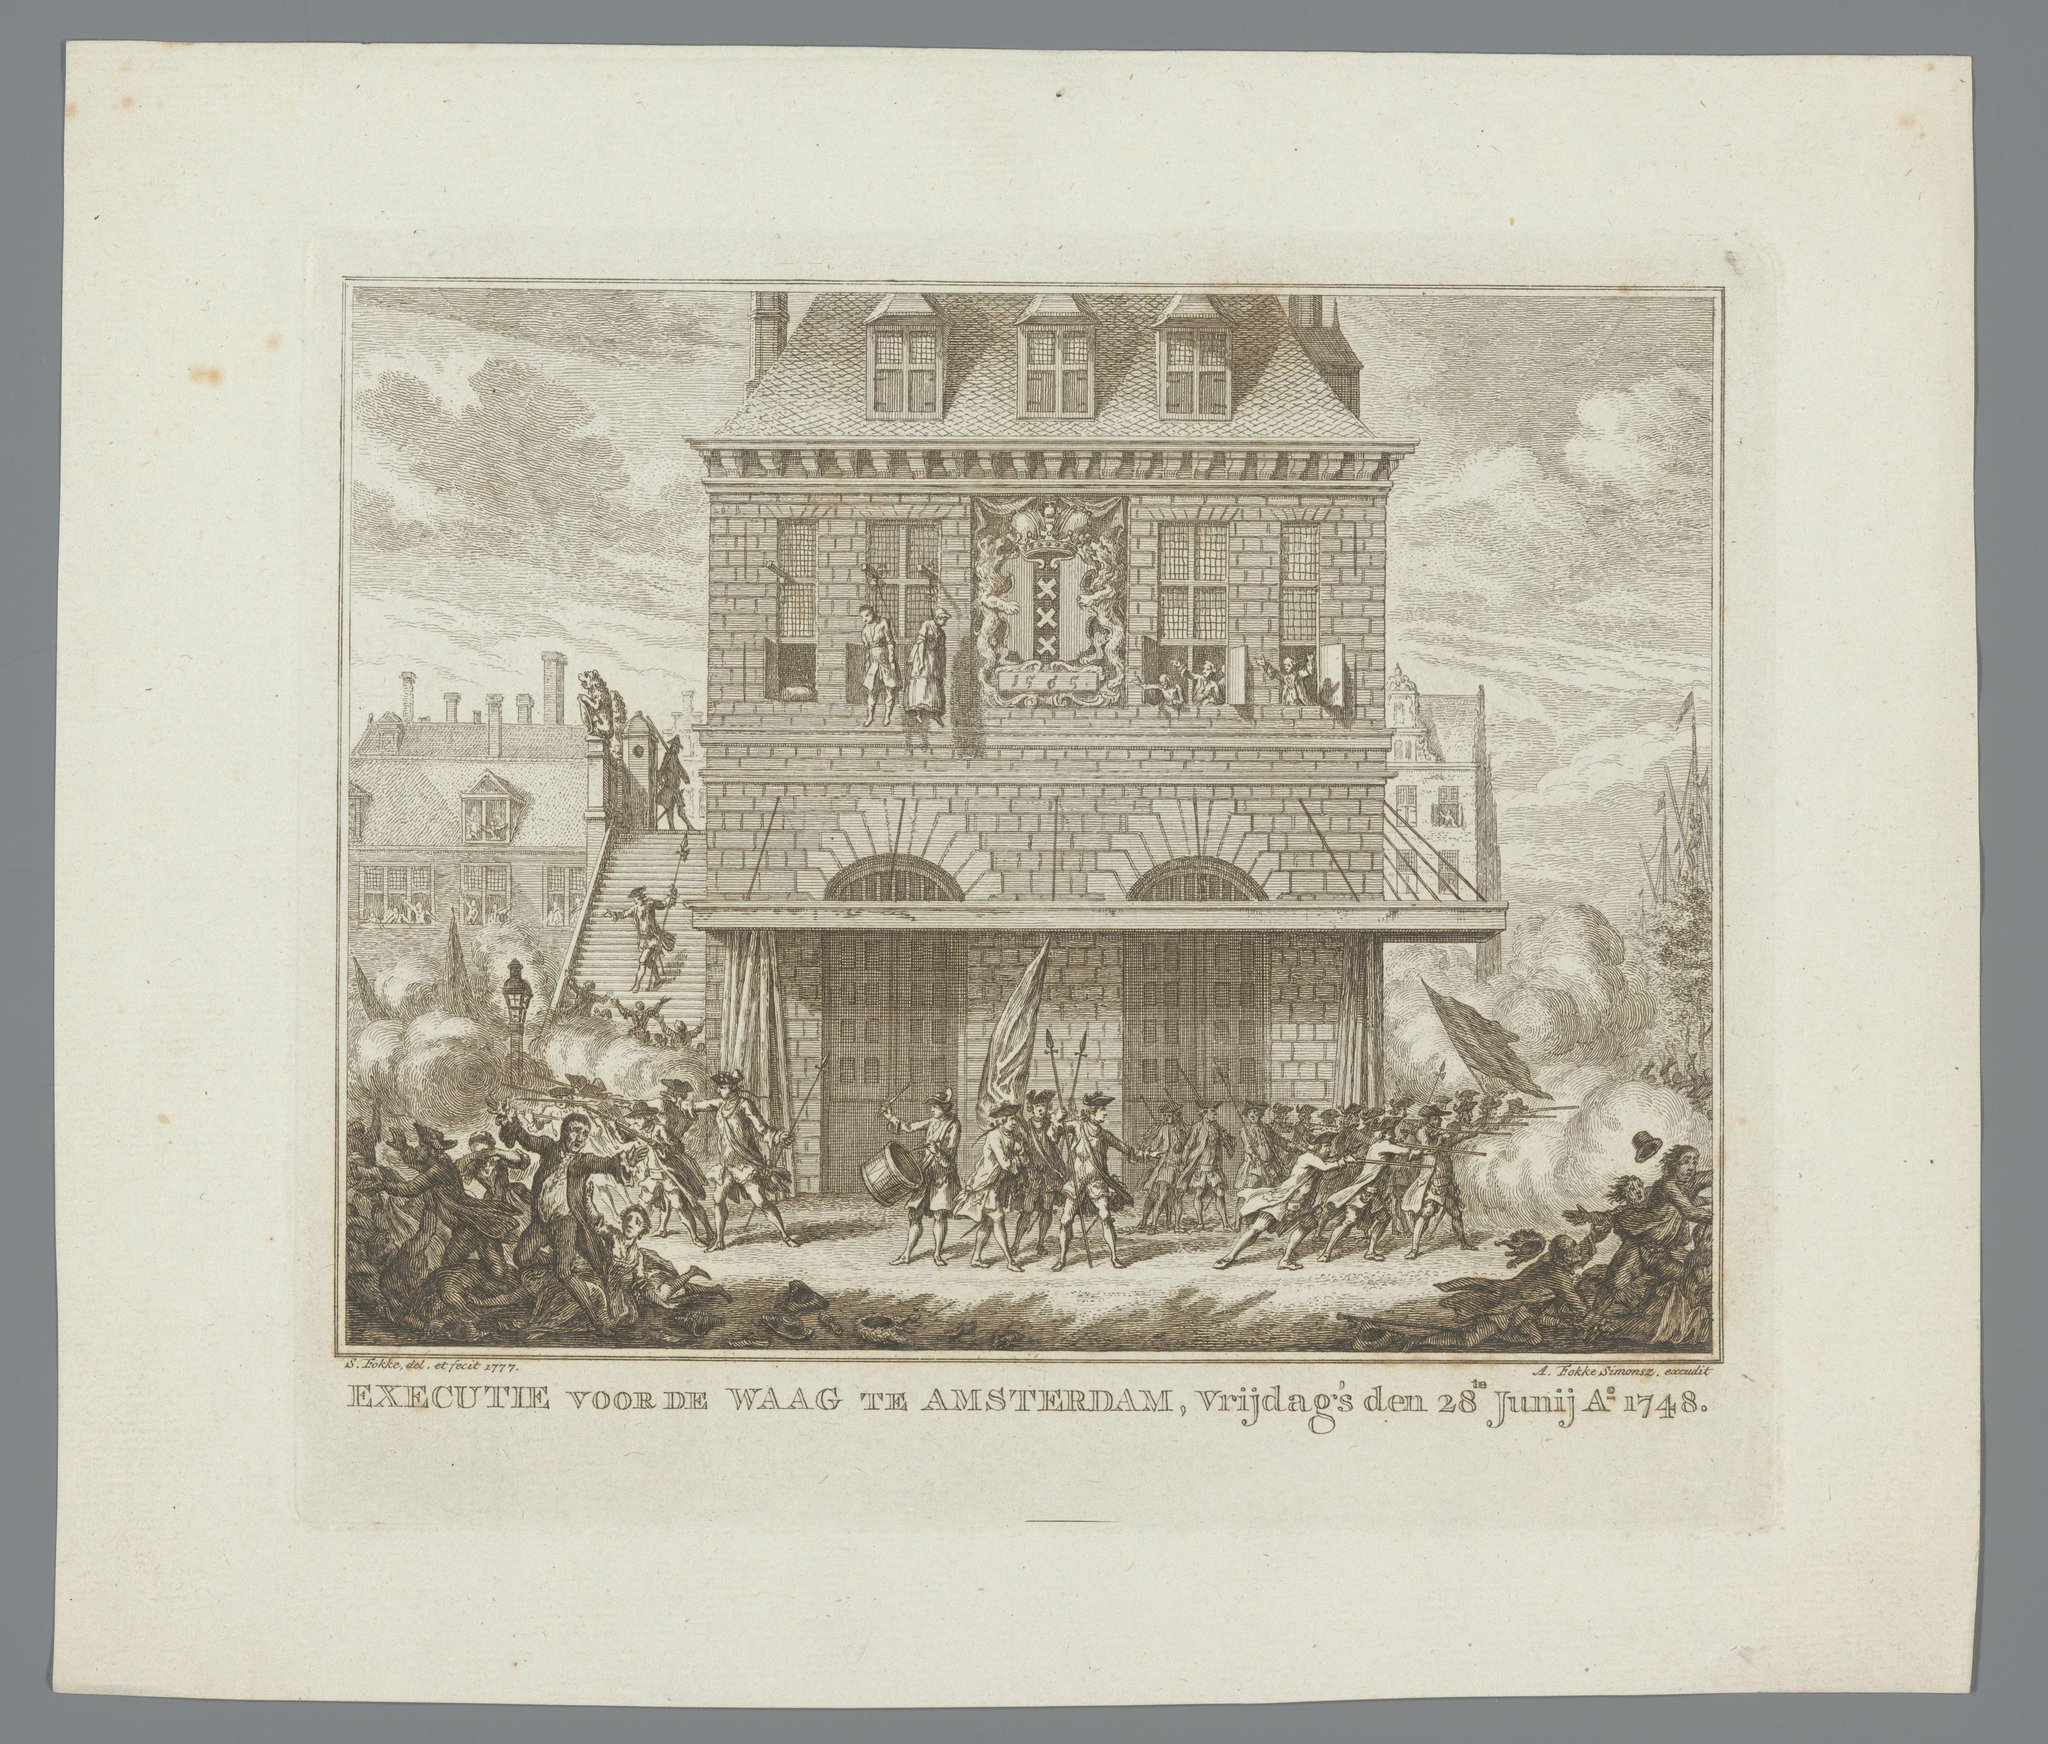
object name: book illustration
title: Executie voor de Waag te Amsterdam, Vrijdag's den 28te Junij Ao. 1748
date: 1777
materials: paper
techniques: engraving, etching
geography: amsterdam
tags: violent death by hanging, death penalty, execution, street-fights, riots, weigh-house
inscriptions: date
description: Onlusten tijdens de ophanging van een man en vrouw (Piet van Dort en de citroen- en gedroogde scholverkoopster Mat van den Nieuwendijk), twee deelnemers aan het Pachtersoproer, aan de Waag te Amsterdam, 28 juni 1748. De schutterij opent het vuur op de toeschouwers.